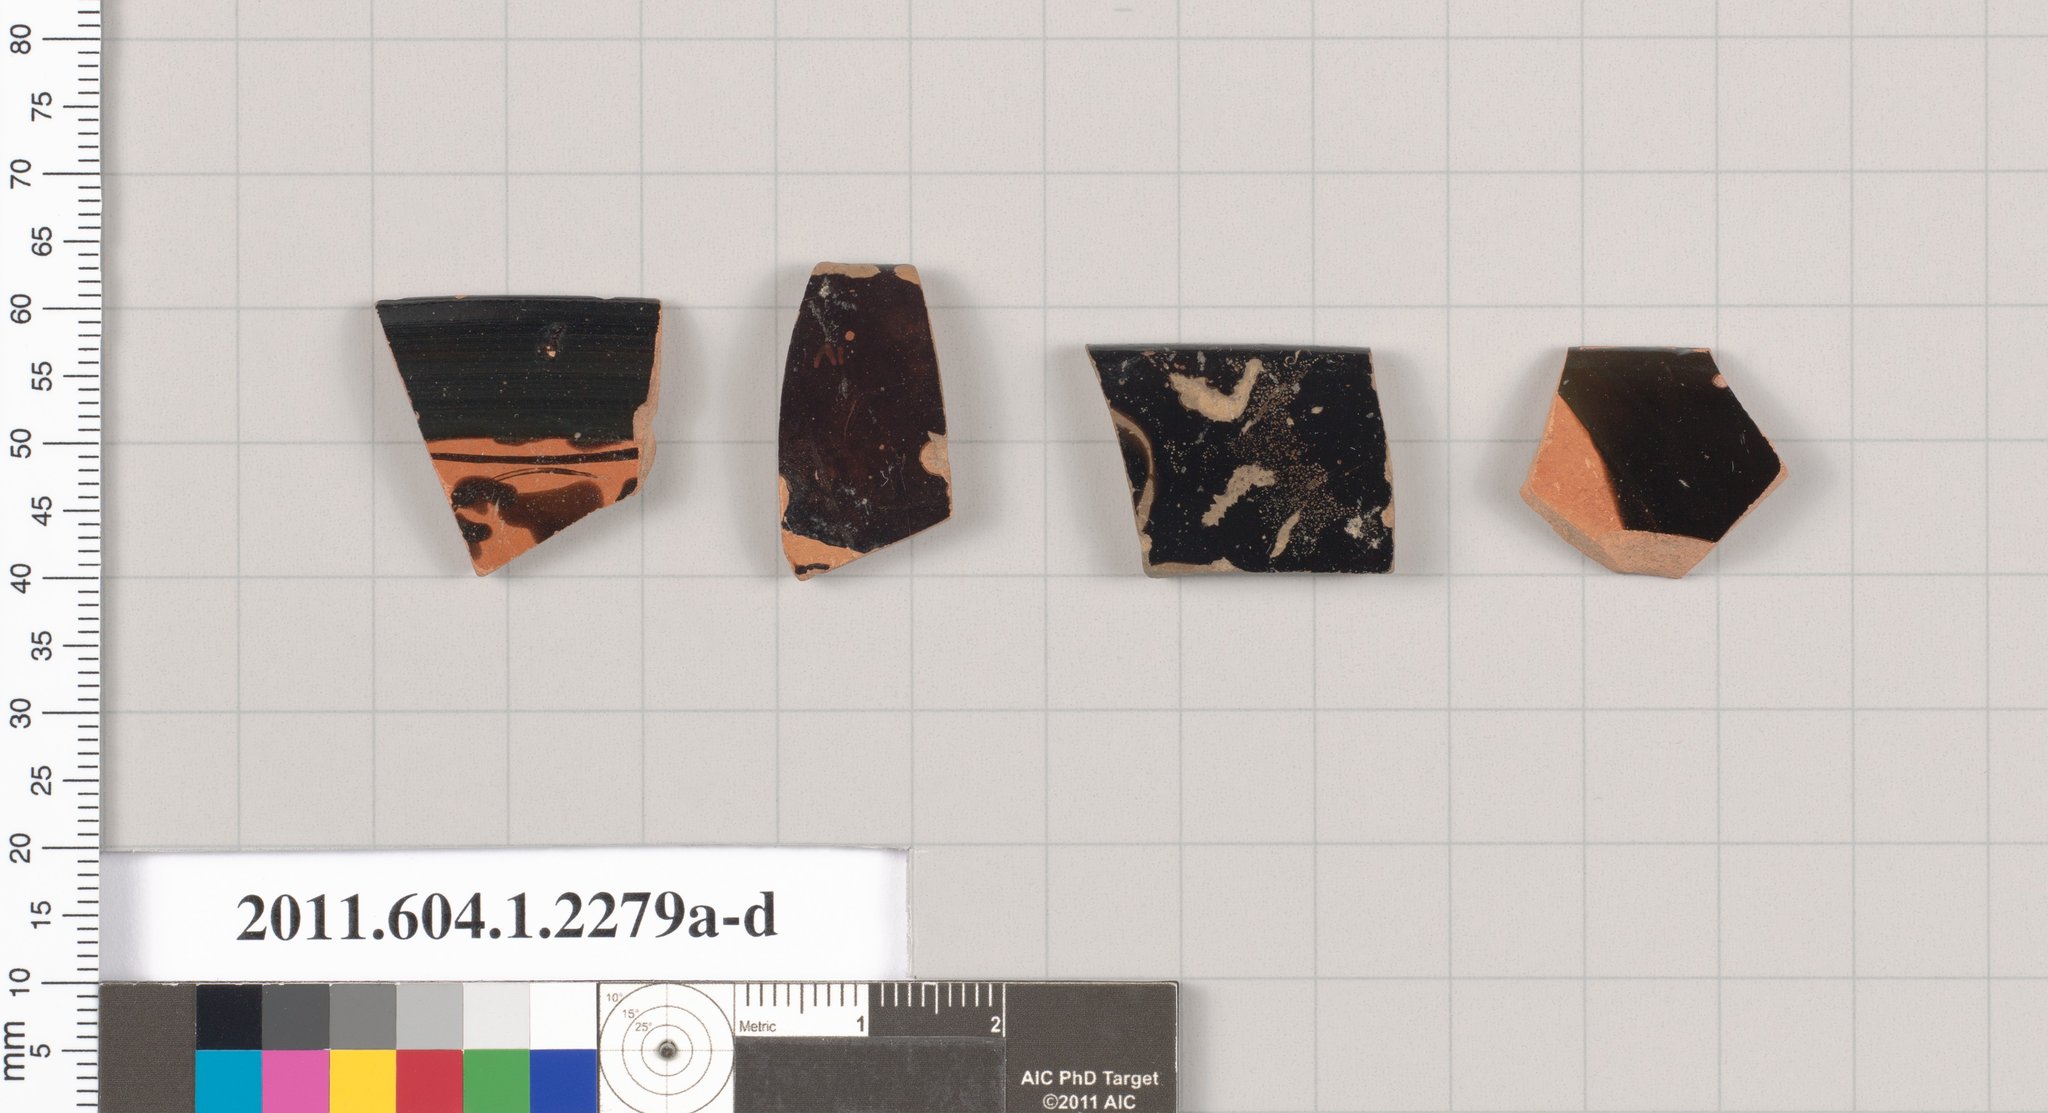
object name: kylix fragment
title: Terracotta rim fragments of kylikes (drinking cups)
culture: greek, attic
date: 500-401 BCE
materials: terracotta